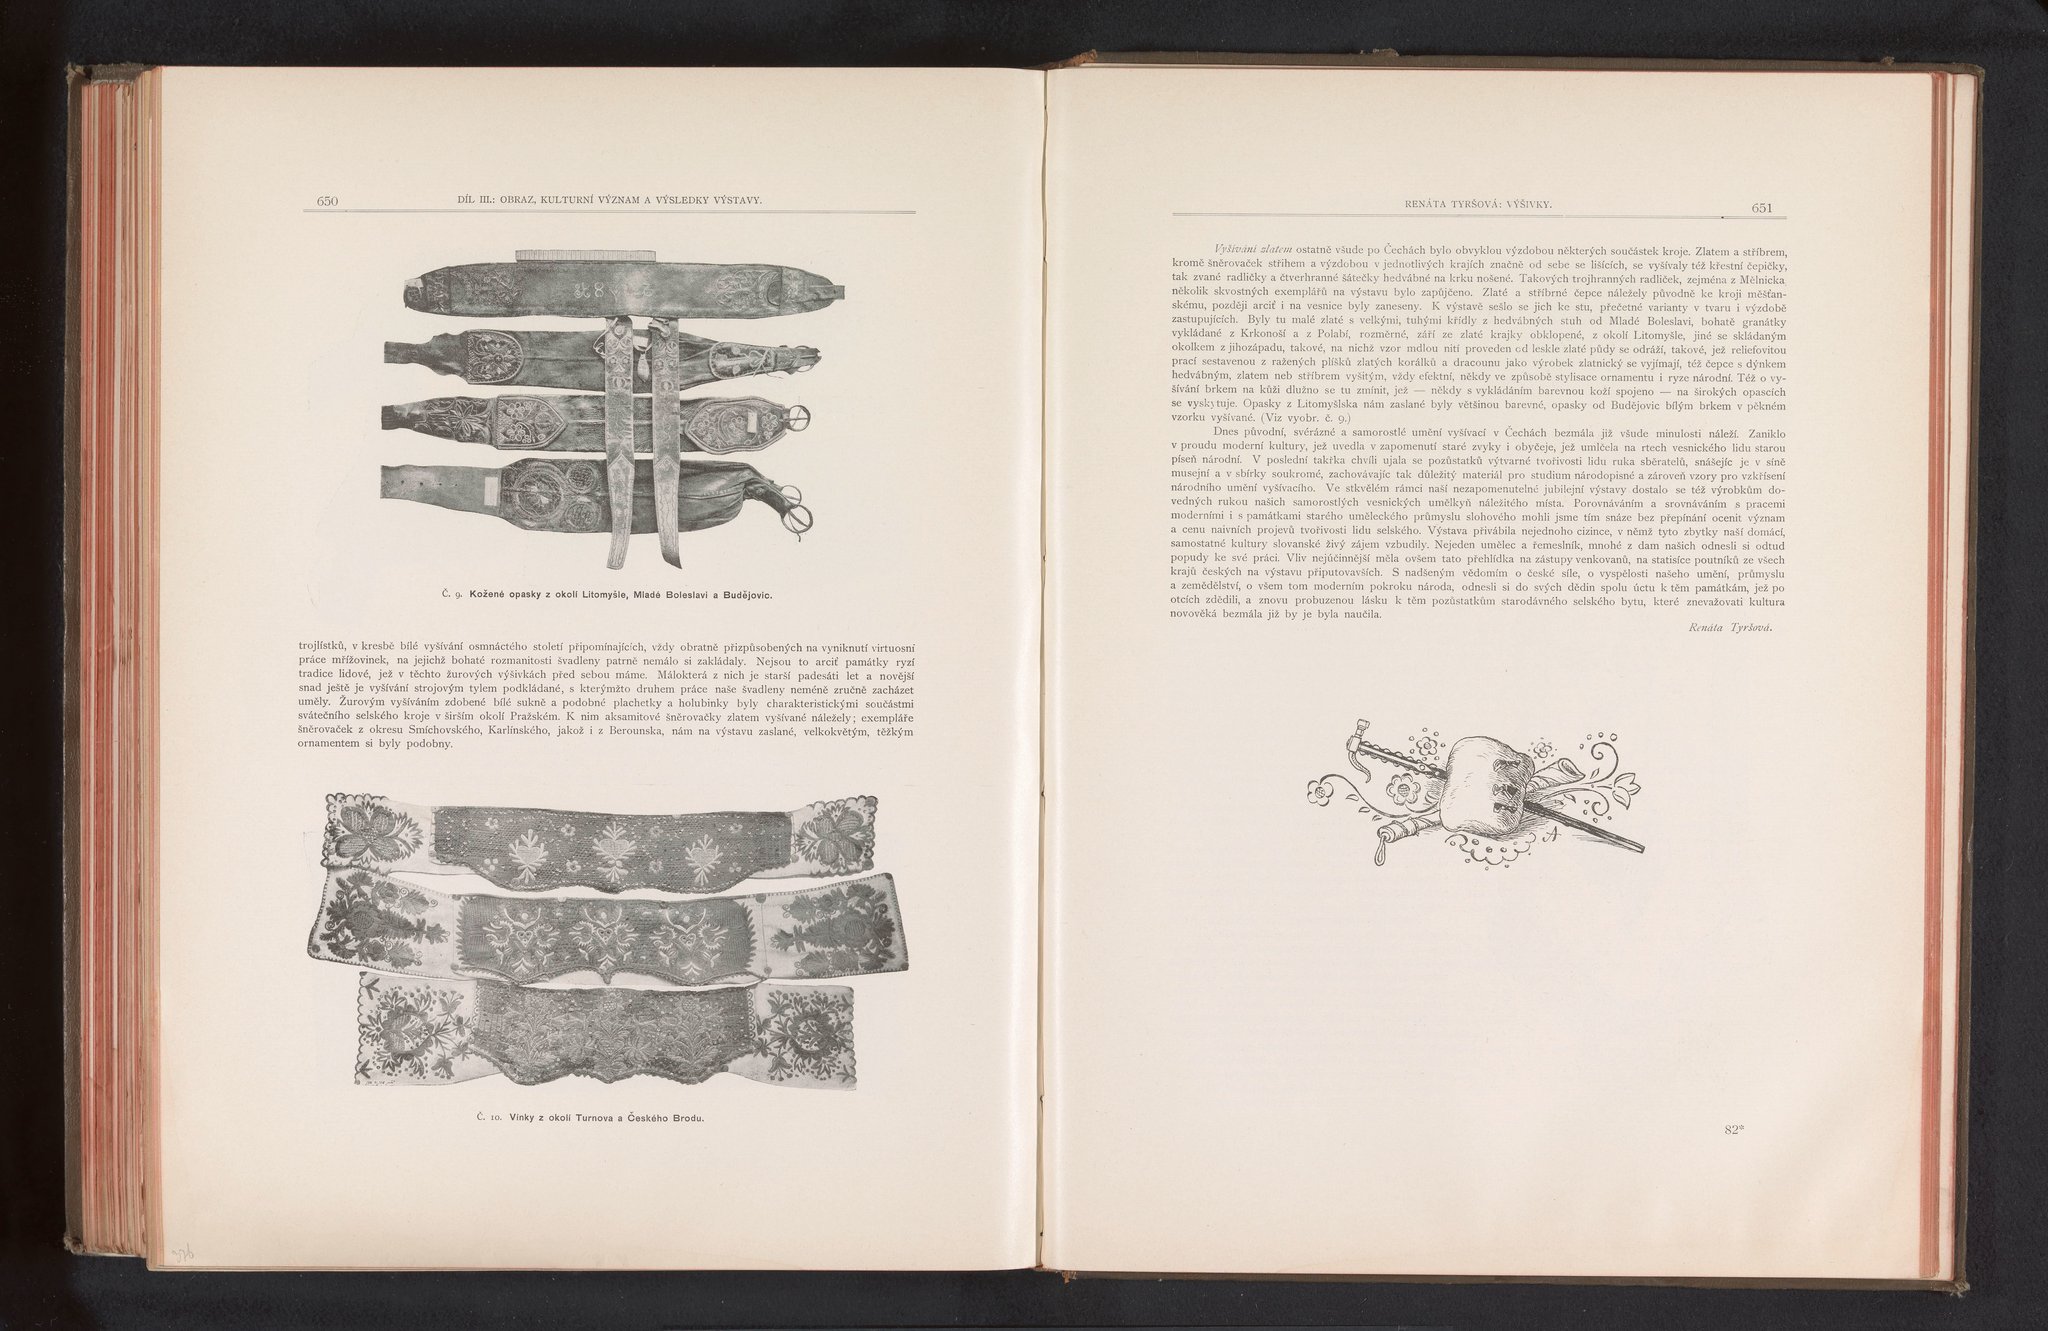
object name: photomechanical print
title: Lederen riemen uit de omgeving van Litomyšl, Mlada Boleslav en České Budějovice en ceinturen uit de omgeving van Turnov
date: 1891-1895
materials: paper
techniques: autotype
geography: prague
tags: belt, girdle, waistband